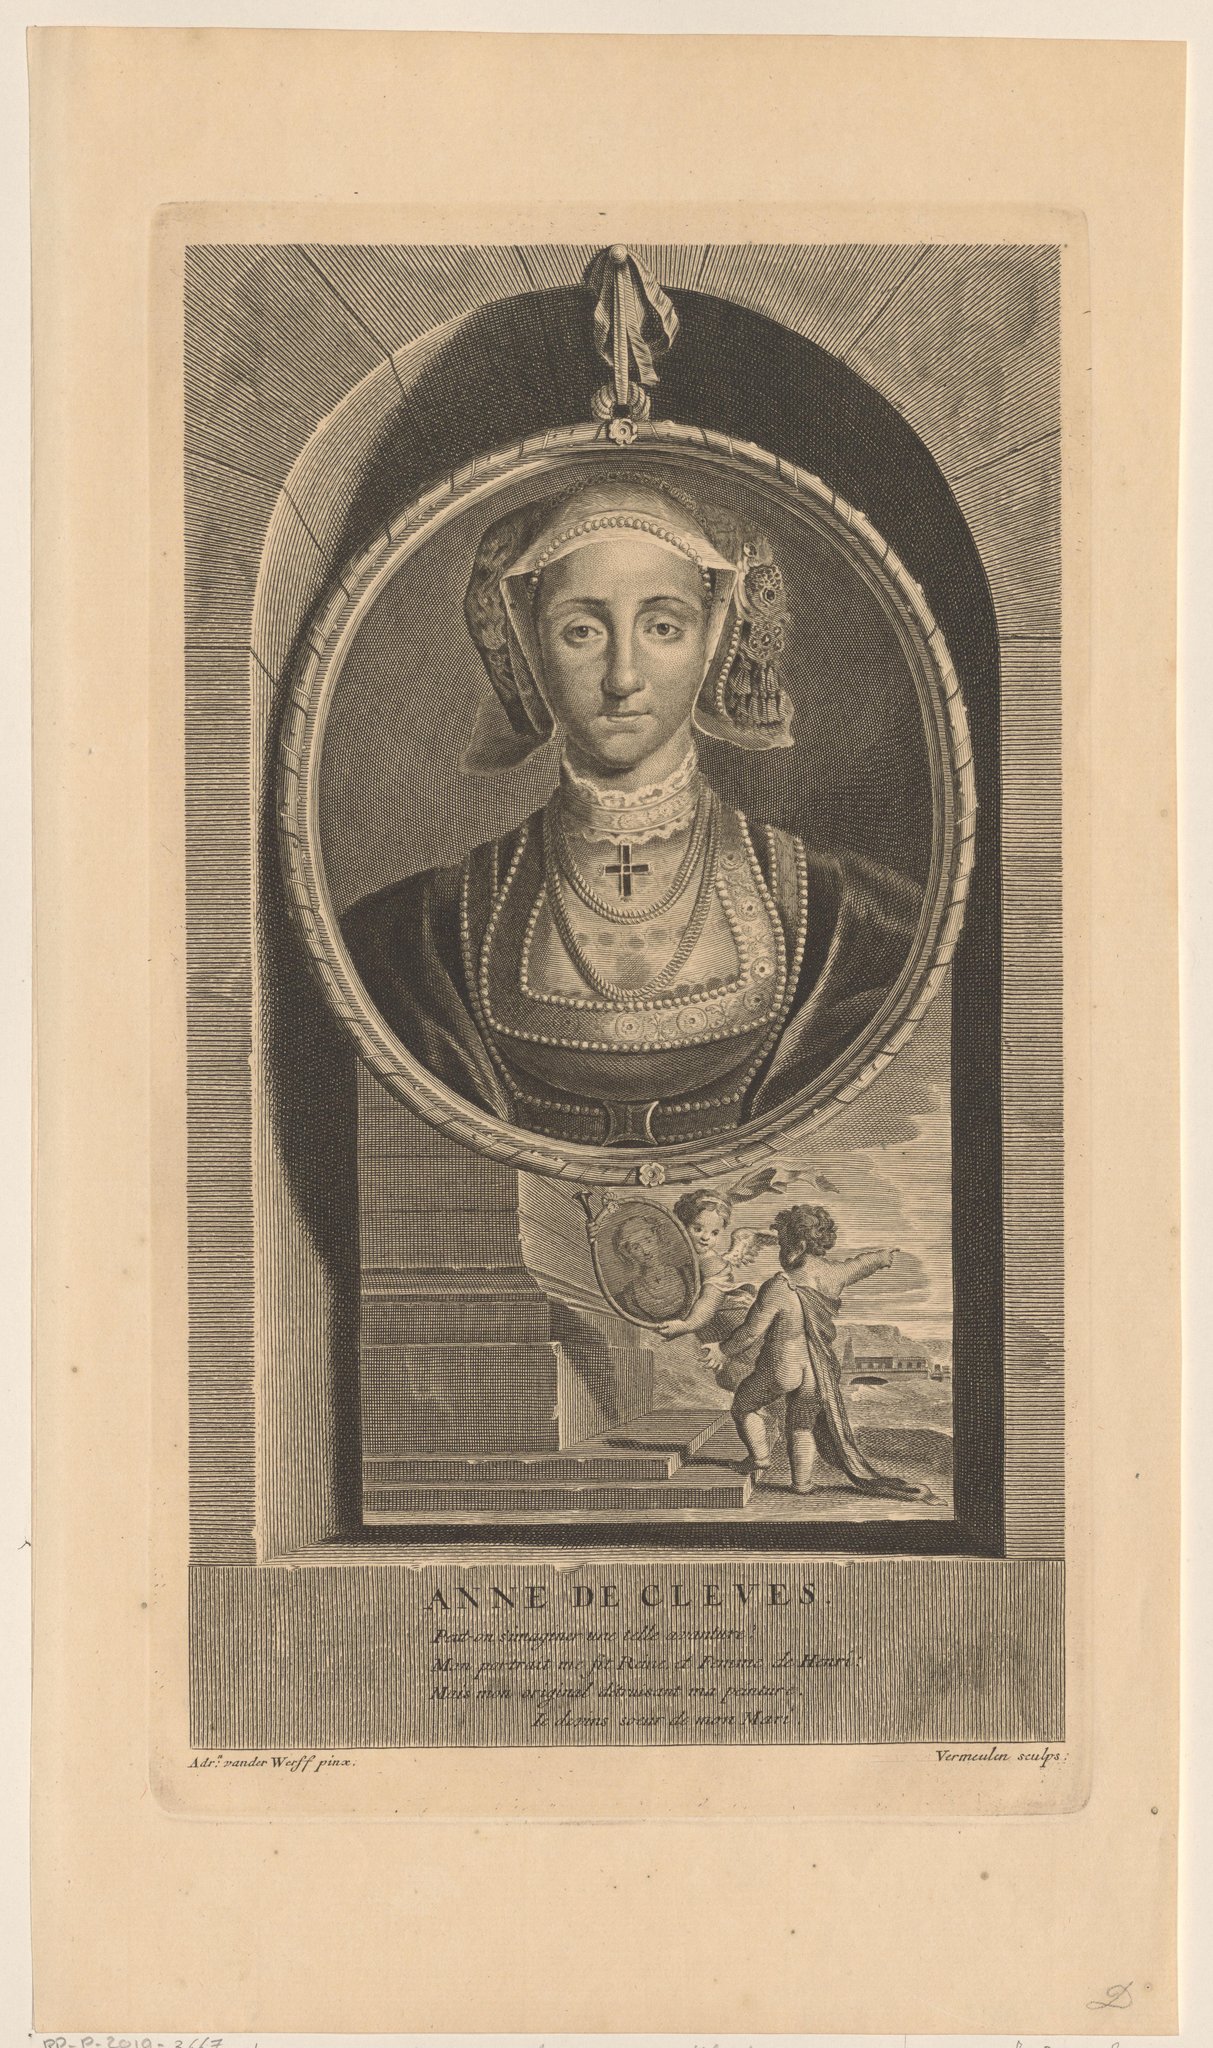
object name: print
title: Portret van Anna van Kleef, koningin van Engeland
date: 1697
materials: paper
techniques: engraving, etching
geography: rotterdam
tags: cleves, historical persons - bb - woman, cupids: 'amores', 'amoretti', 'putti'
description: Prent ook gebruikt in: Larrey, Isaac de. Histoire d'Angleterre, d'Ecosse, et d'Irlande. 4 dln. Rotterdam: Reinier Leers, 1697-1713.